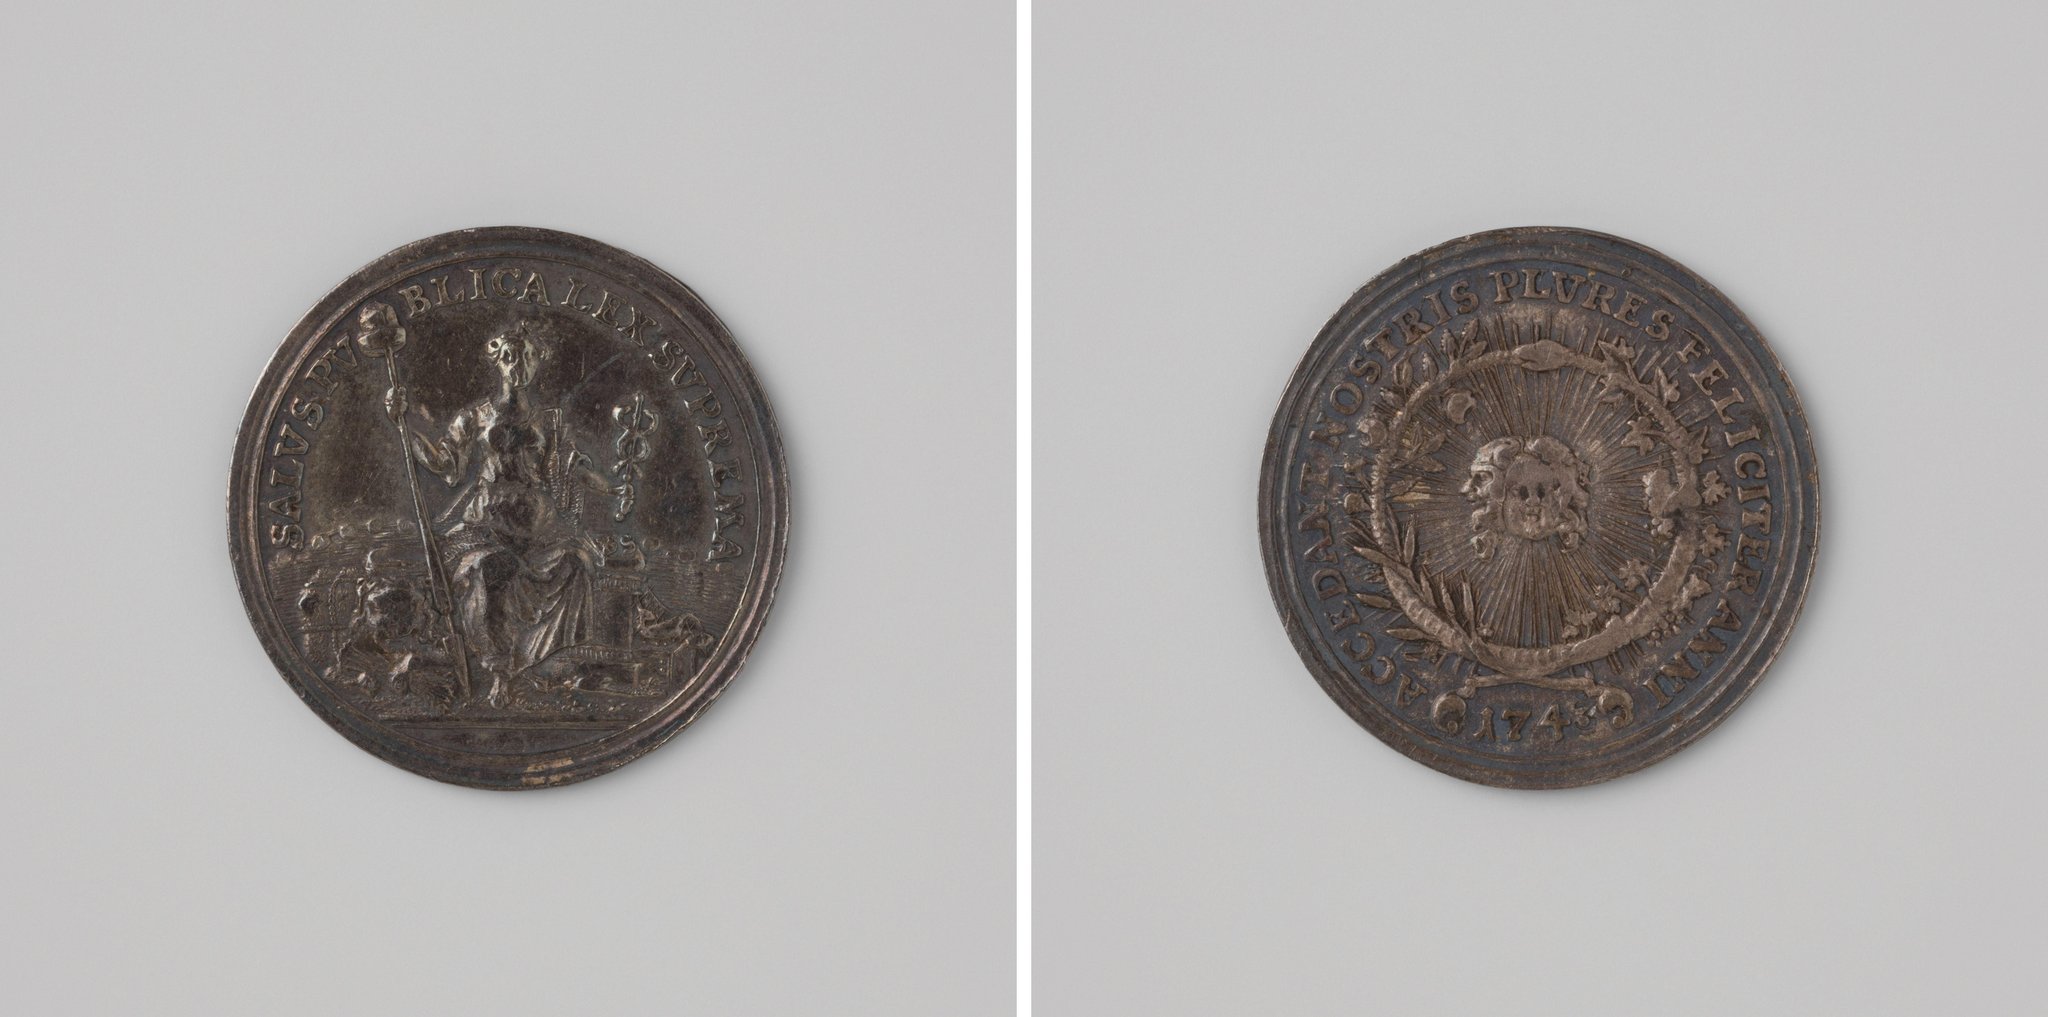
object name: new year medal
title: Aanvang van het jaar 1743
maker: martinus holtzhey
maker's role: medailleur, muntmaker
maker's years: 1697-1764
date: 1742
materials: silver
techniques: engraving, striking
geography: amsterdam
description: Zilveren penning. Voorzijde: Holland, afgebeeld als vrouw met vrijheidshoed op speer en Mercuriusstaf zit in de Hollandse tuin tussen koopmanswaar, naast haar leeuw met pijlenbundel en bijbel op een altaar binnen omschrift. Keerzijde: stralende zon binnen slangerond, omwonden door bloemen en vruchten binnen omschrift